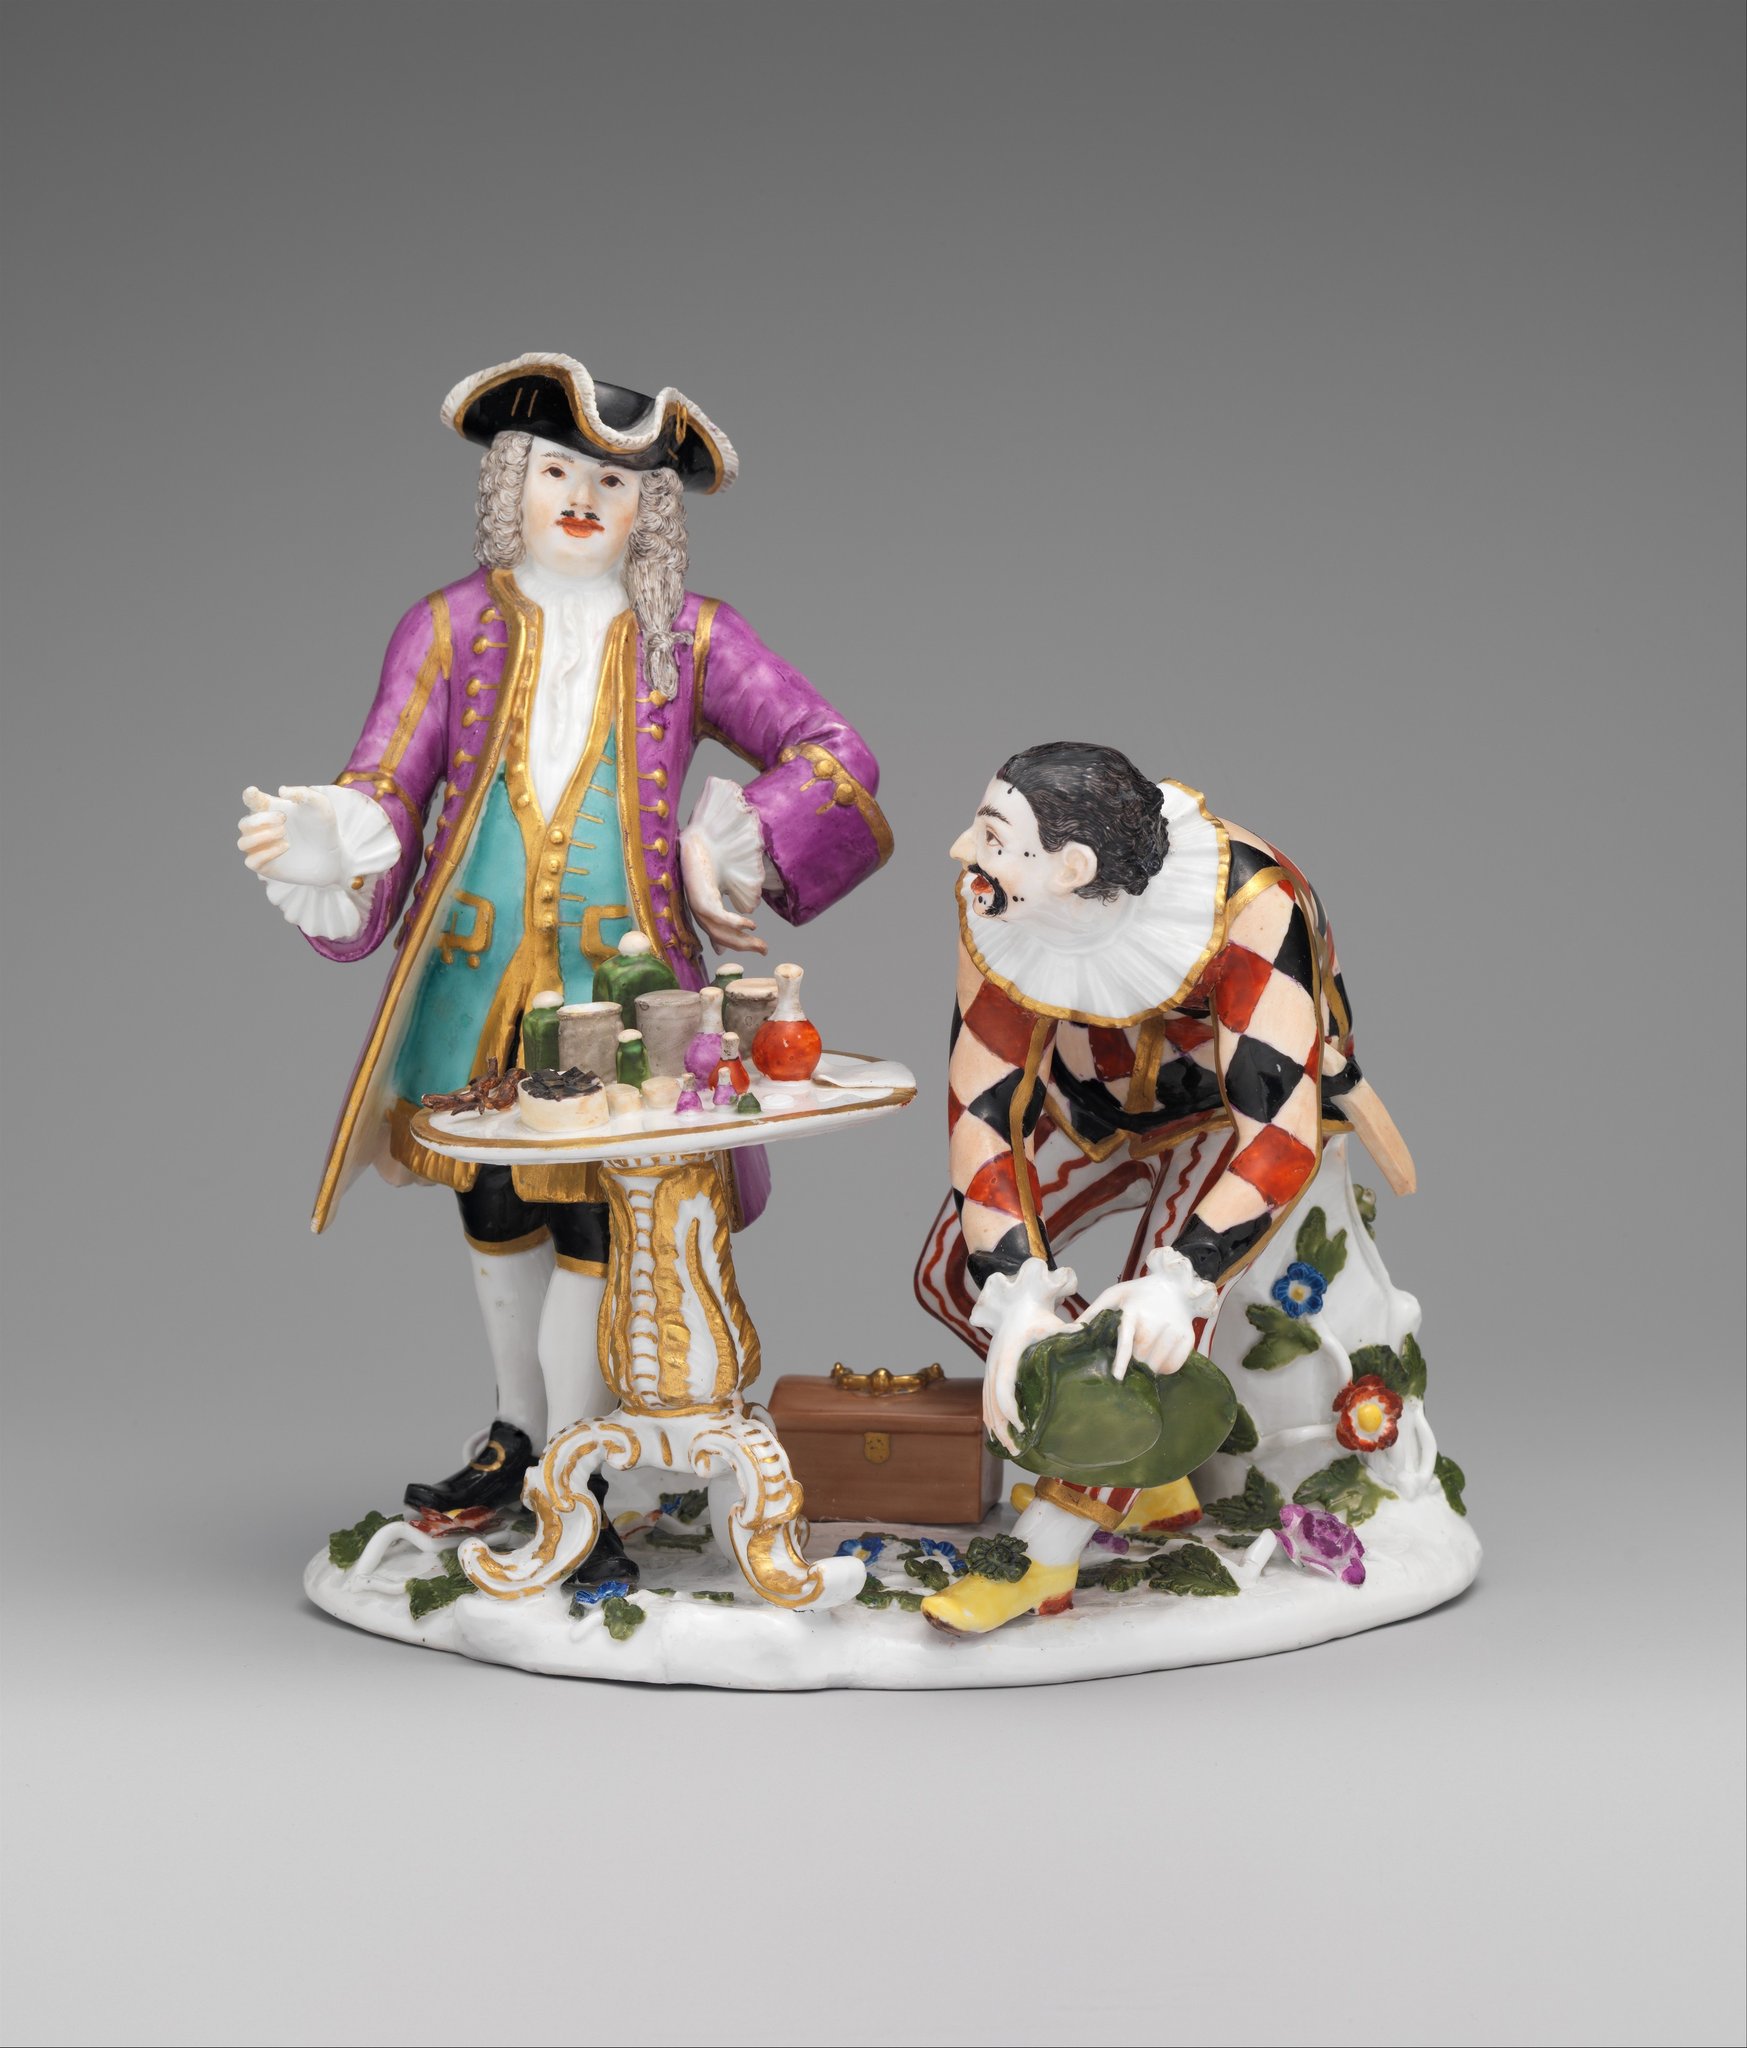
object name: group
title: Harlequin and the Quack Doctor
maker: meissen manufactory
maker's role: manufactory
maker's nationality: german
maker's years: 1710-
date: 1745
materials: hard paste porcelain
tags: men,doctors